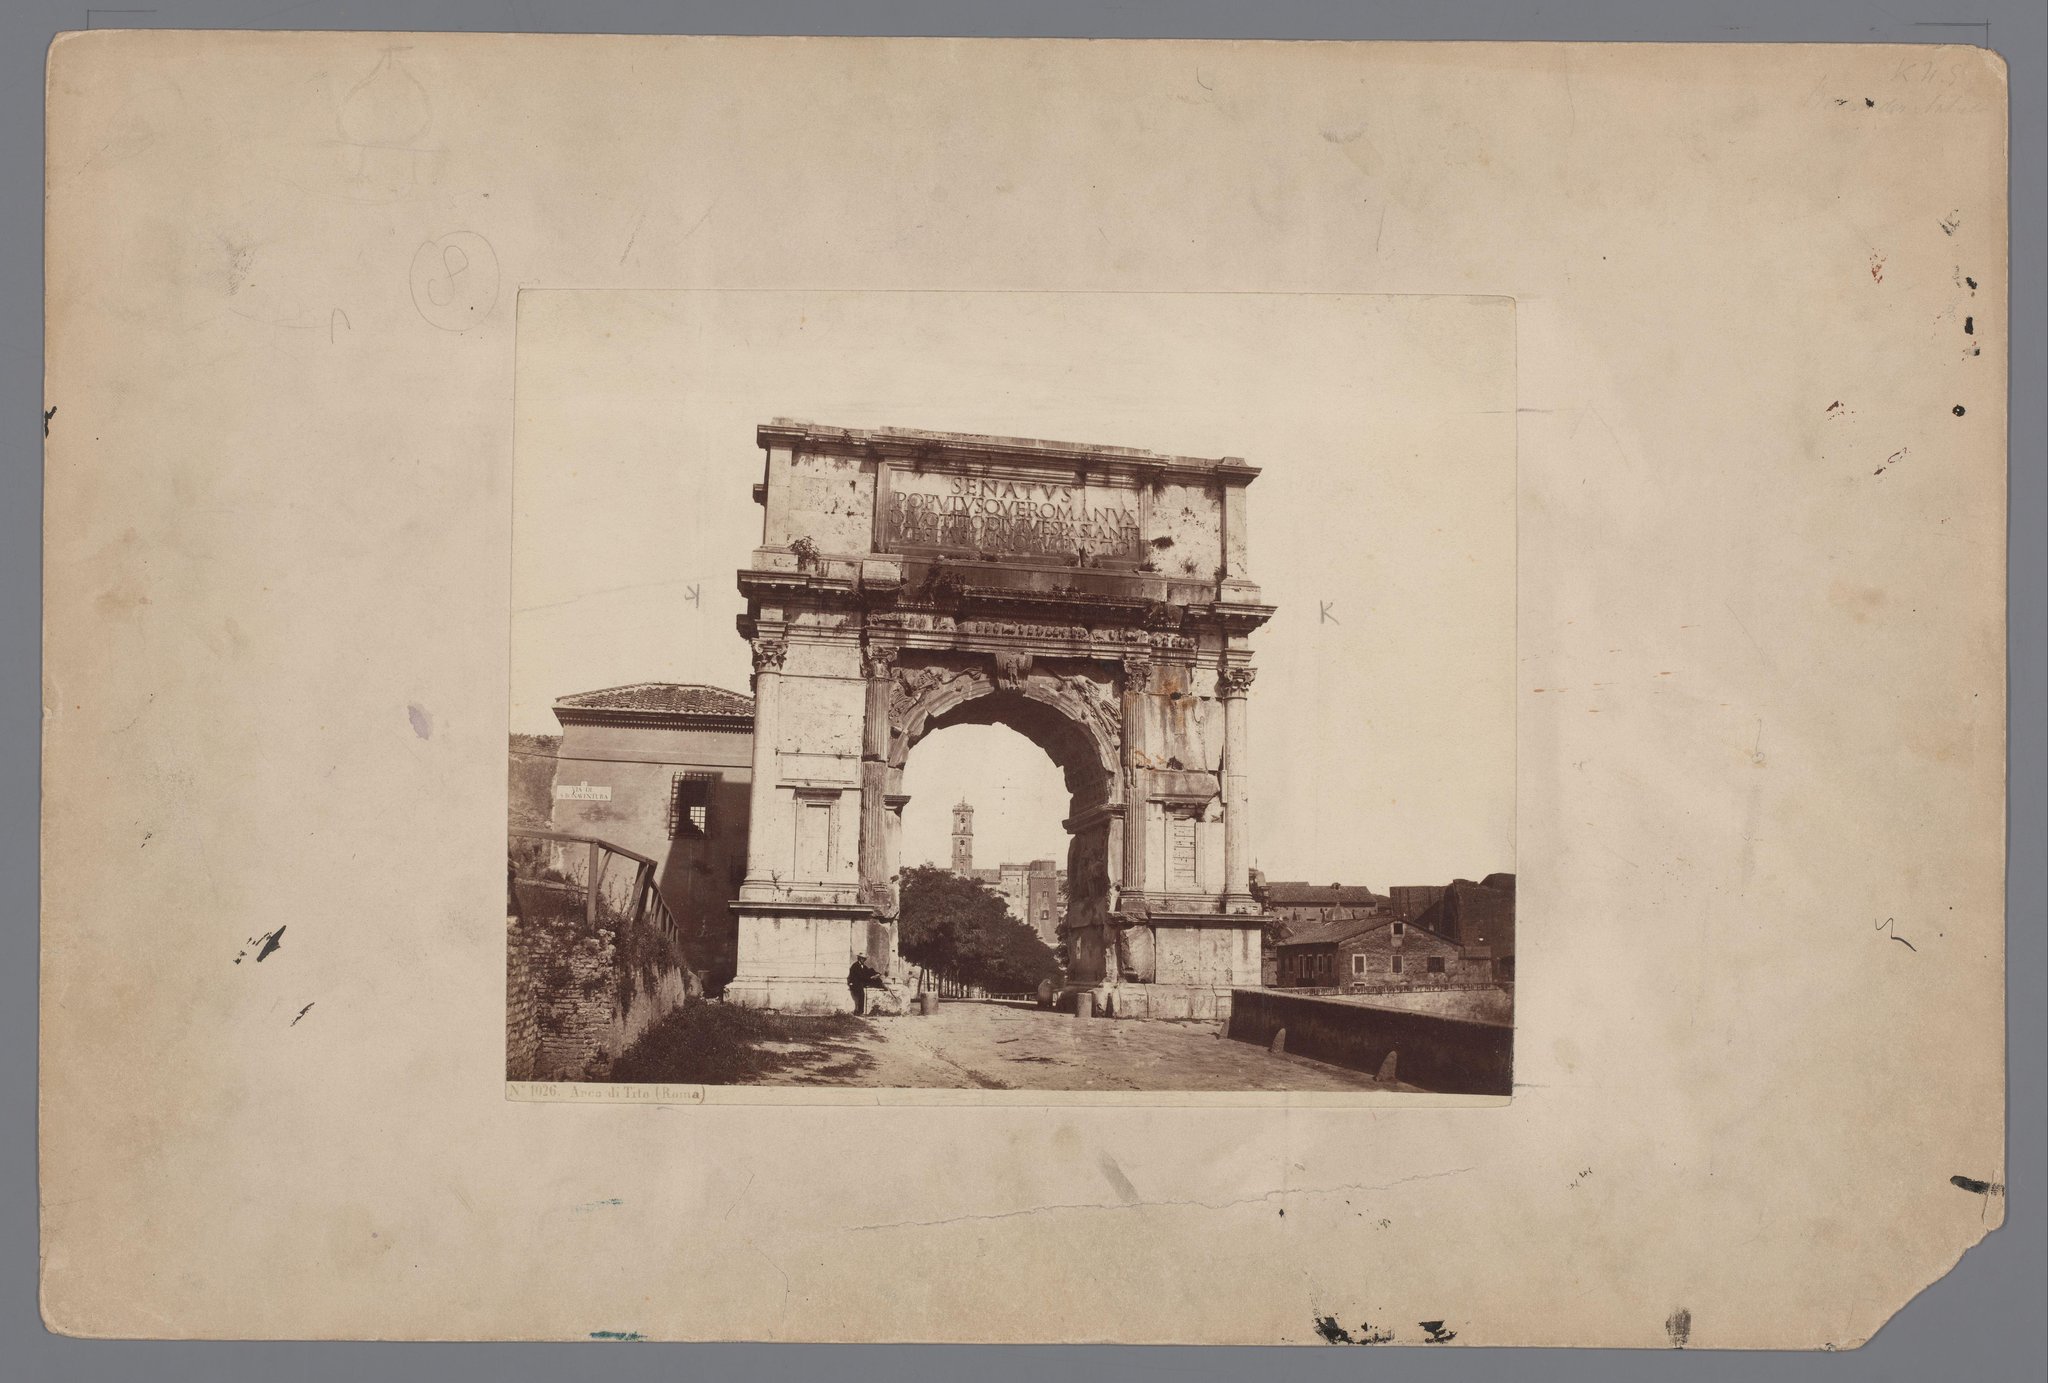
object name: photograph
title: Arco di Tito (Roma)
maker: giorgio sommer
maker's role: fotograaf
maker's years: 1834-1914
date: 1857-1914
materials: cardboard, paper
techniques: albumen print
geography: rome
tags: ruin of a building ~ architecture, triumphal arch, rome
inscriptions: number: ‘No. 1026.’, number: ‘22’, collector's mark: ‘RIJKS SCHOOL VOOR KUNSTNIJVERHEID/ GROEP’